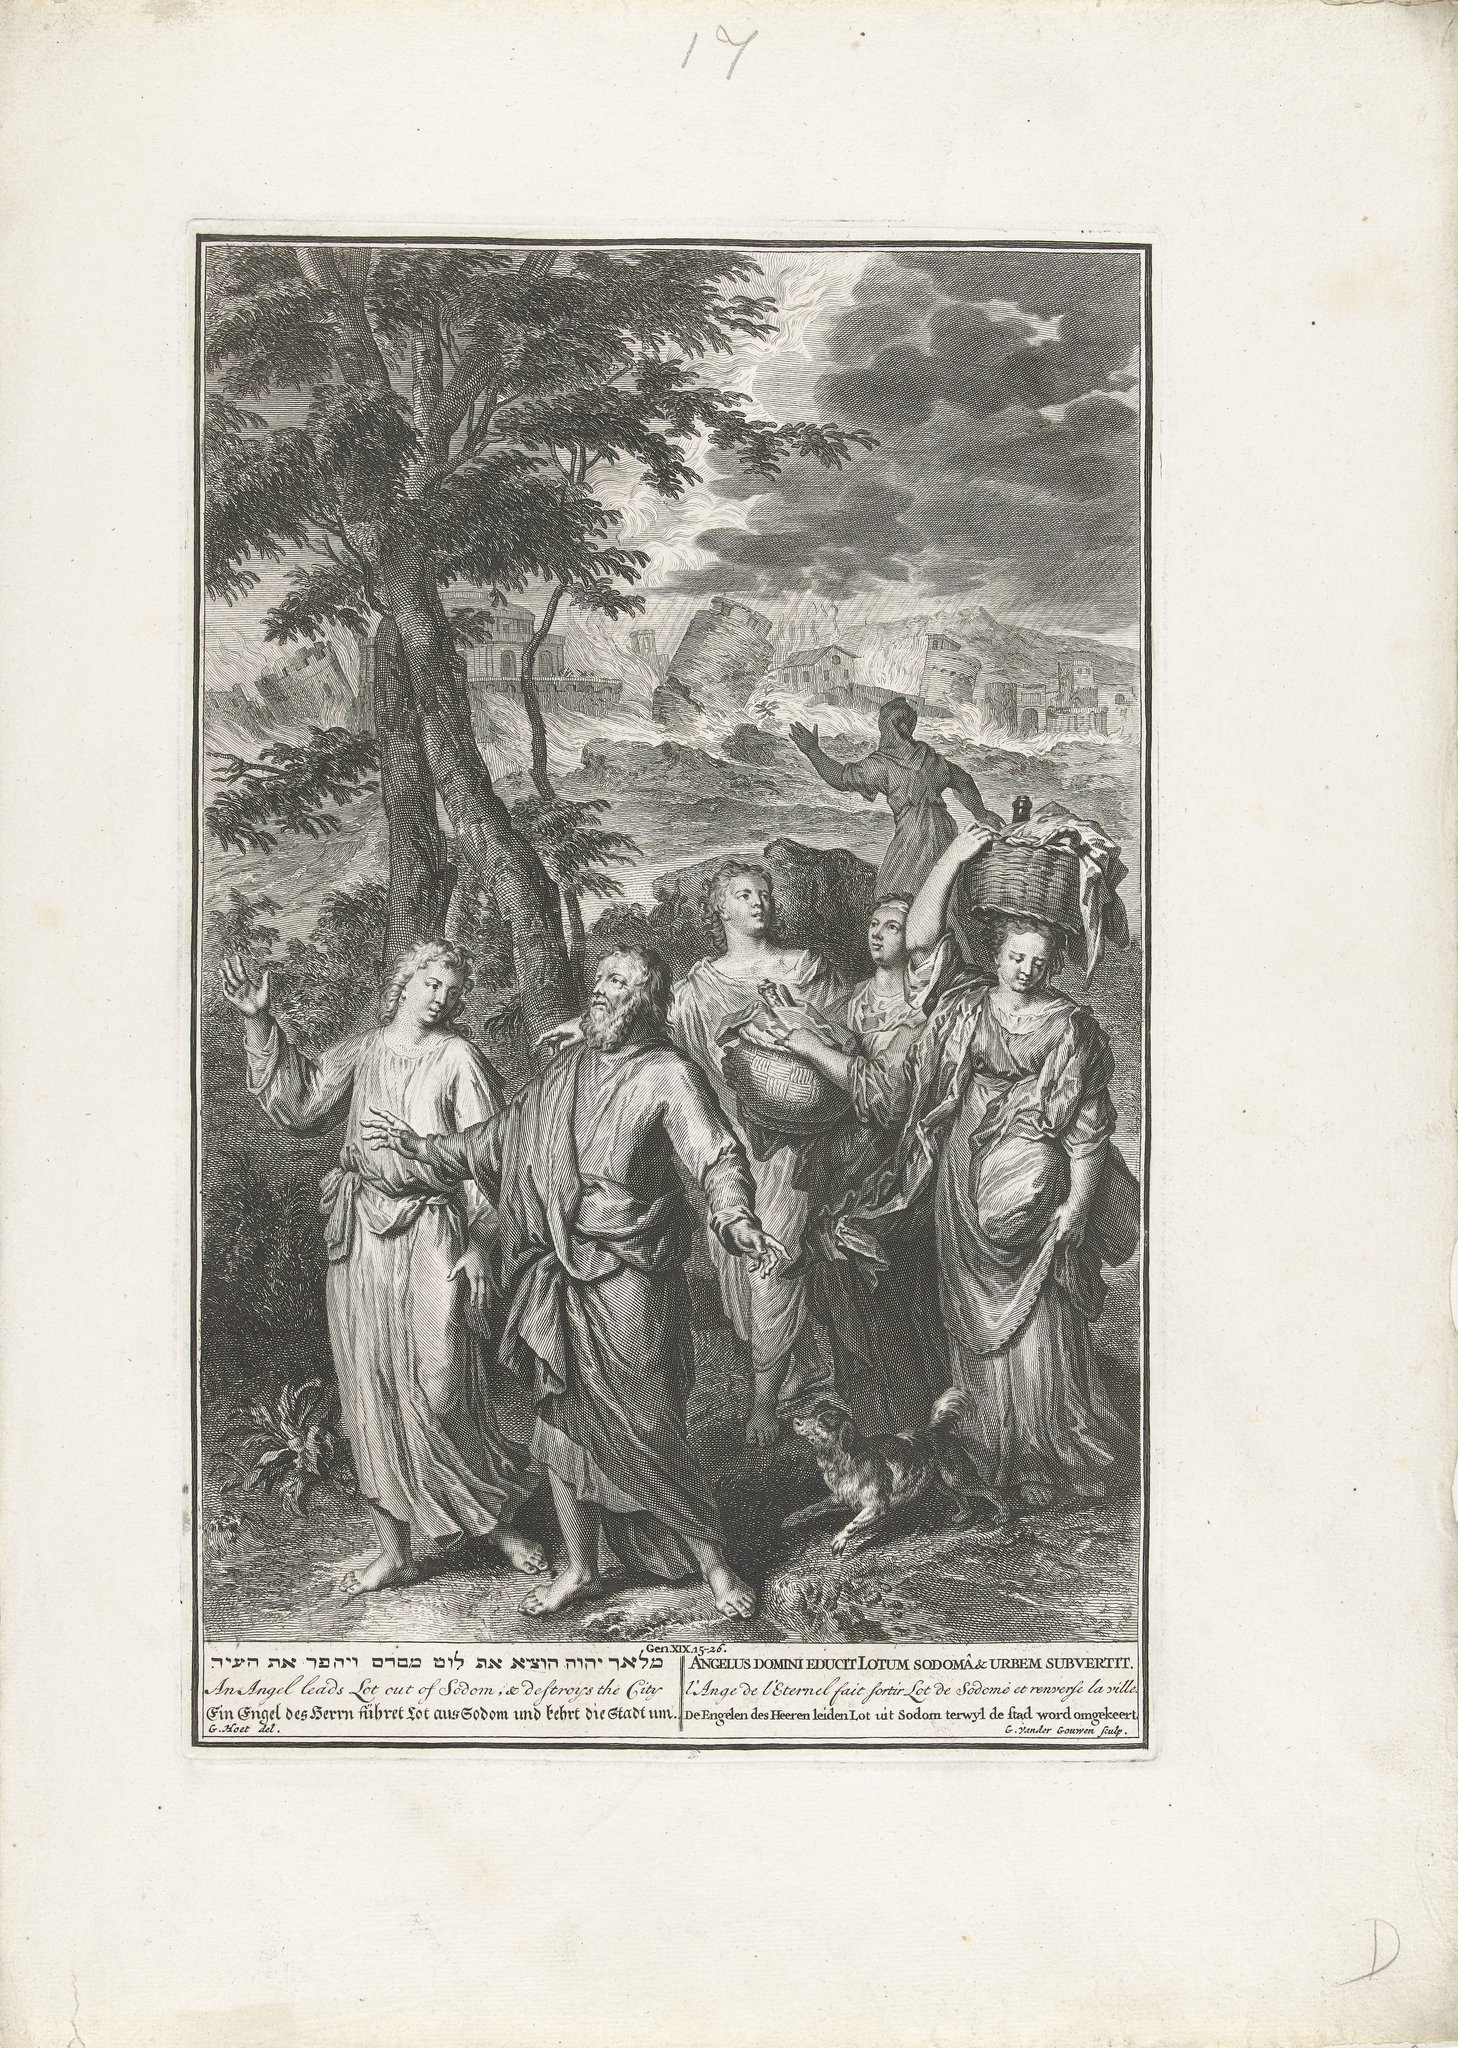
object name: print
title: Vlucht van Lot uit Sodom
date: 1728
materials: paper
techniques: engraving, etching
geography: the hague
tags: the destruction of sodom and gomorrah: lot and his family flee to zoar, carrying their belongings; an angel may be showing the way (genesis 19:24-29)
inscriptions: collector's mark: Lugt 2228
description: Lot vlucht uit Sodom met zijn drie dochters, begeleid door een engel. Op de achtergrond het brandende Sodom en de vrouw van Lot als zoutpilaar. (Gen. 19:15-26). De prent heeft een Hebreeuws, Latijns, Frans, Engels, Duits en Nederlands onderschrift.